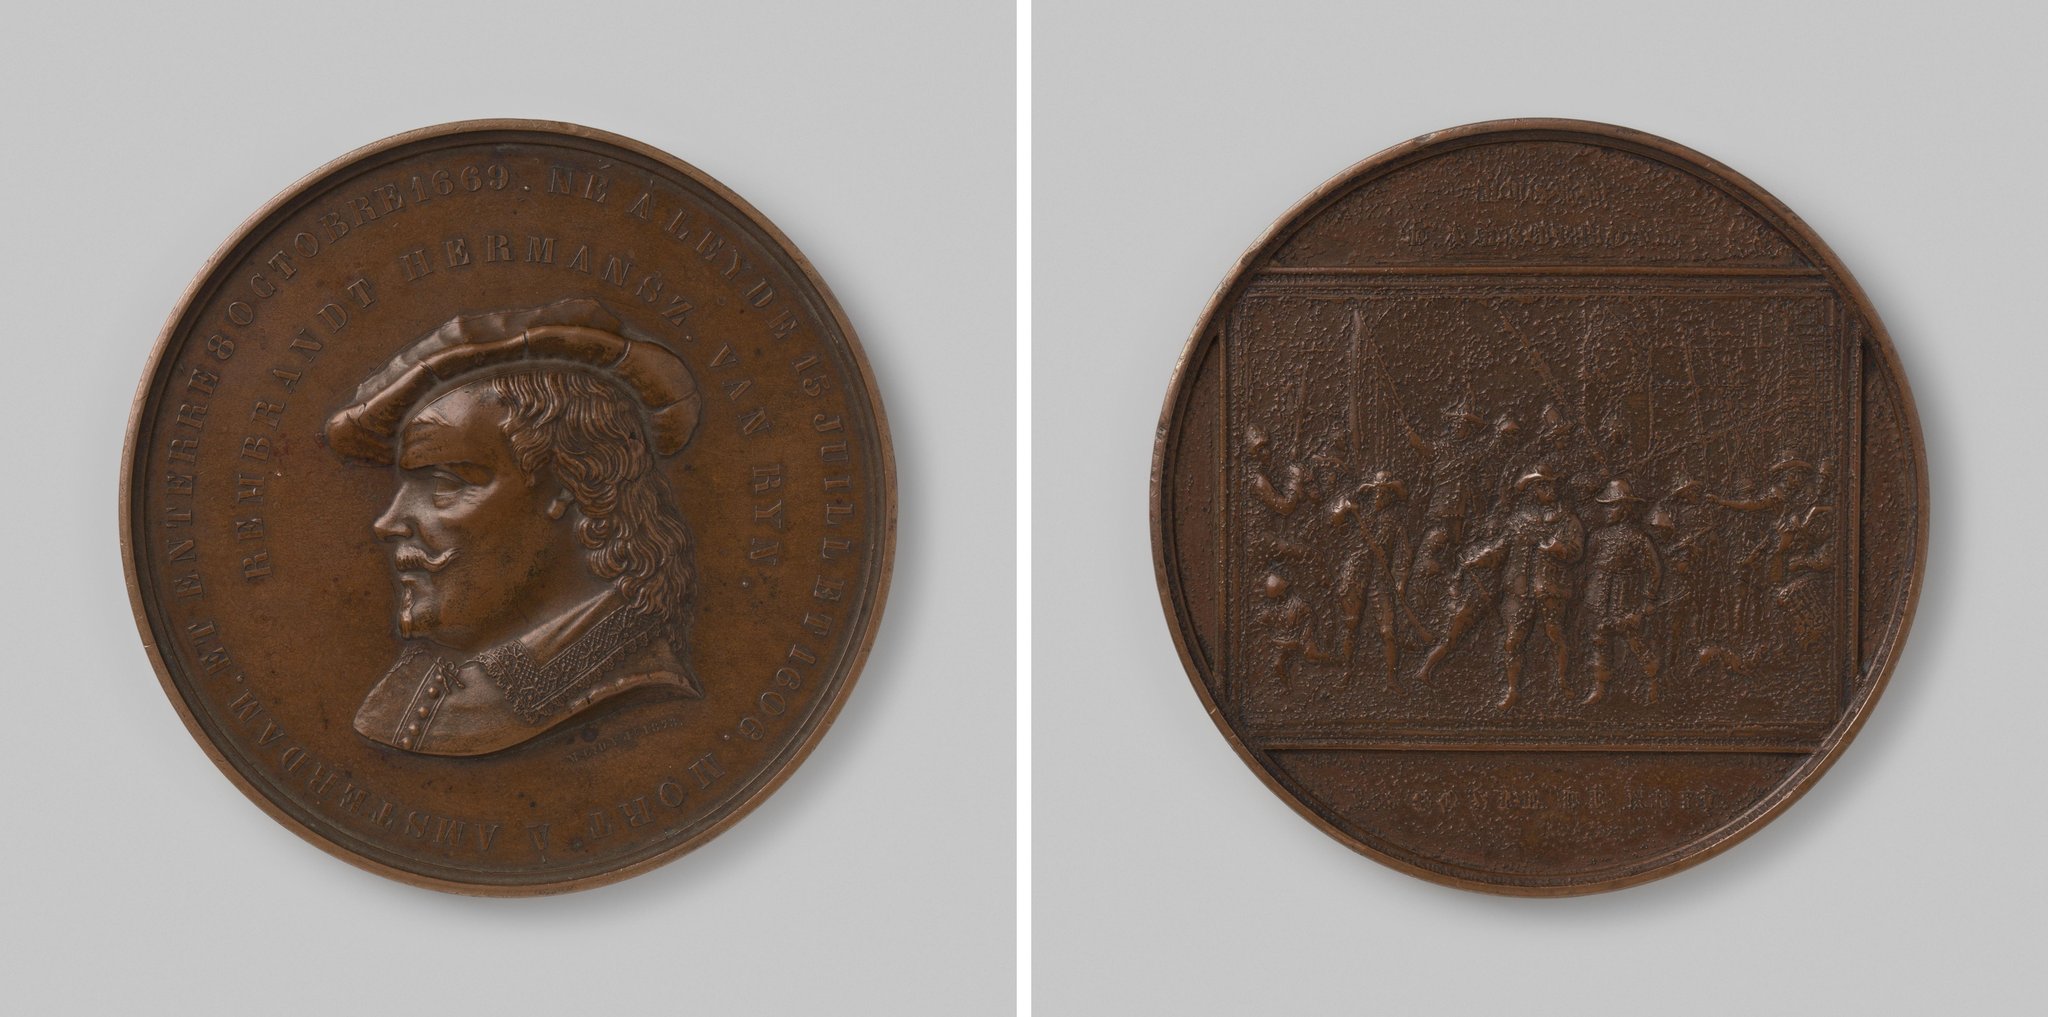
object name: history medal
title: The Night Watch by Rembrandt van Rijn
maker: moses cohen de vries junior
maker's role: diamantslijper, graveur, medailleur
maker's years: 1807-1883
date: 1873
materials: bronze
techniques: striking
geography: netherlands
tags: leiden, amsterdam, painter, print maker, draughtsman, rembrandt van rijn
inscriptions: signature and date: ‘v.z.: M.C.D.V. Jr. 1873’, inscription: ‘v.z. REMBRANDT HERMANSZ. VAN RIJN / NE A LEYDE 15 JUILLET 1606. MORT A AMSTERDAM. ET ENTERRE 8 OCTOBRE 1669. k.z.(boven) MUSEE / D'AMSTERDAM; k.z.(onder) LA RONDE DE NUIT’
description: Rembrandt van Rijn is regarded as the Netherlands’ most important painter. Medals relating to him have been made time and again, often when his year of birth or death is commemorated. Throughout his life the sculptor Piet Esser (1914-2004) was fascinated by Rembrandt, in particular the artist’s head. He made numerous portrait medals, each one different, modelling them by hand, after which he fired them in clay or had them cast in bronze.